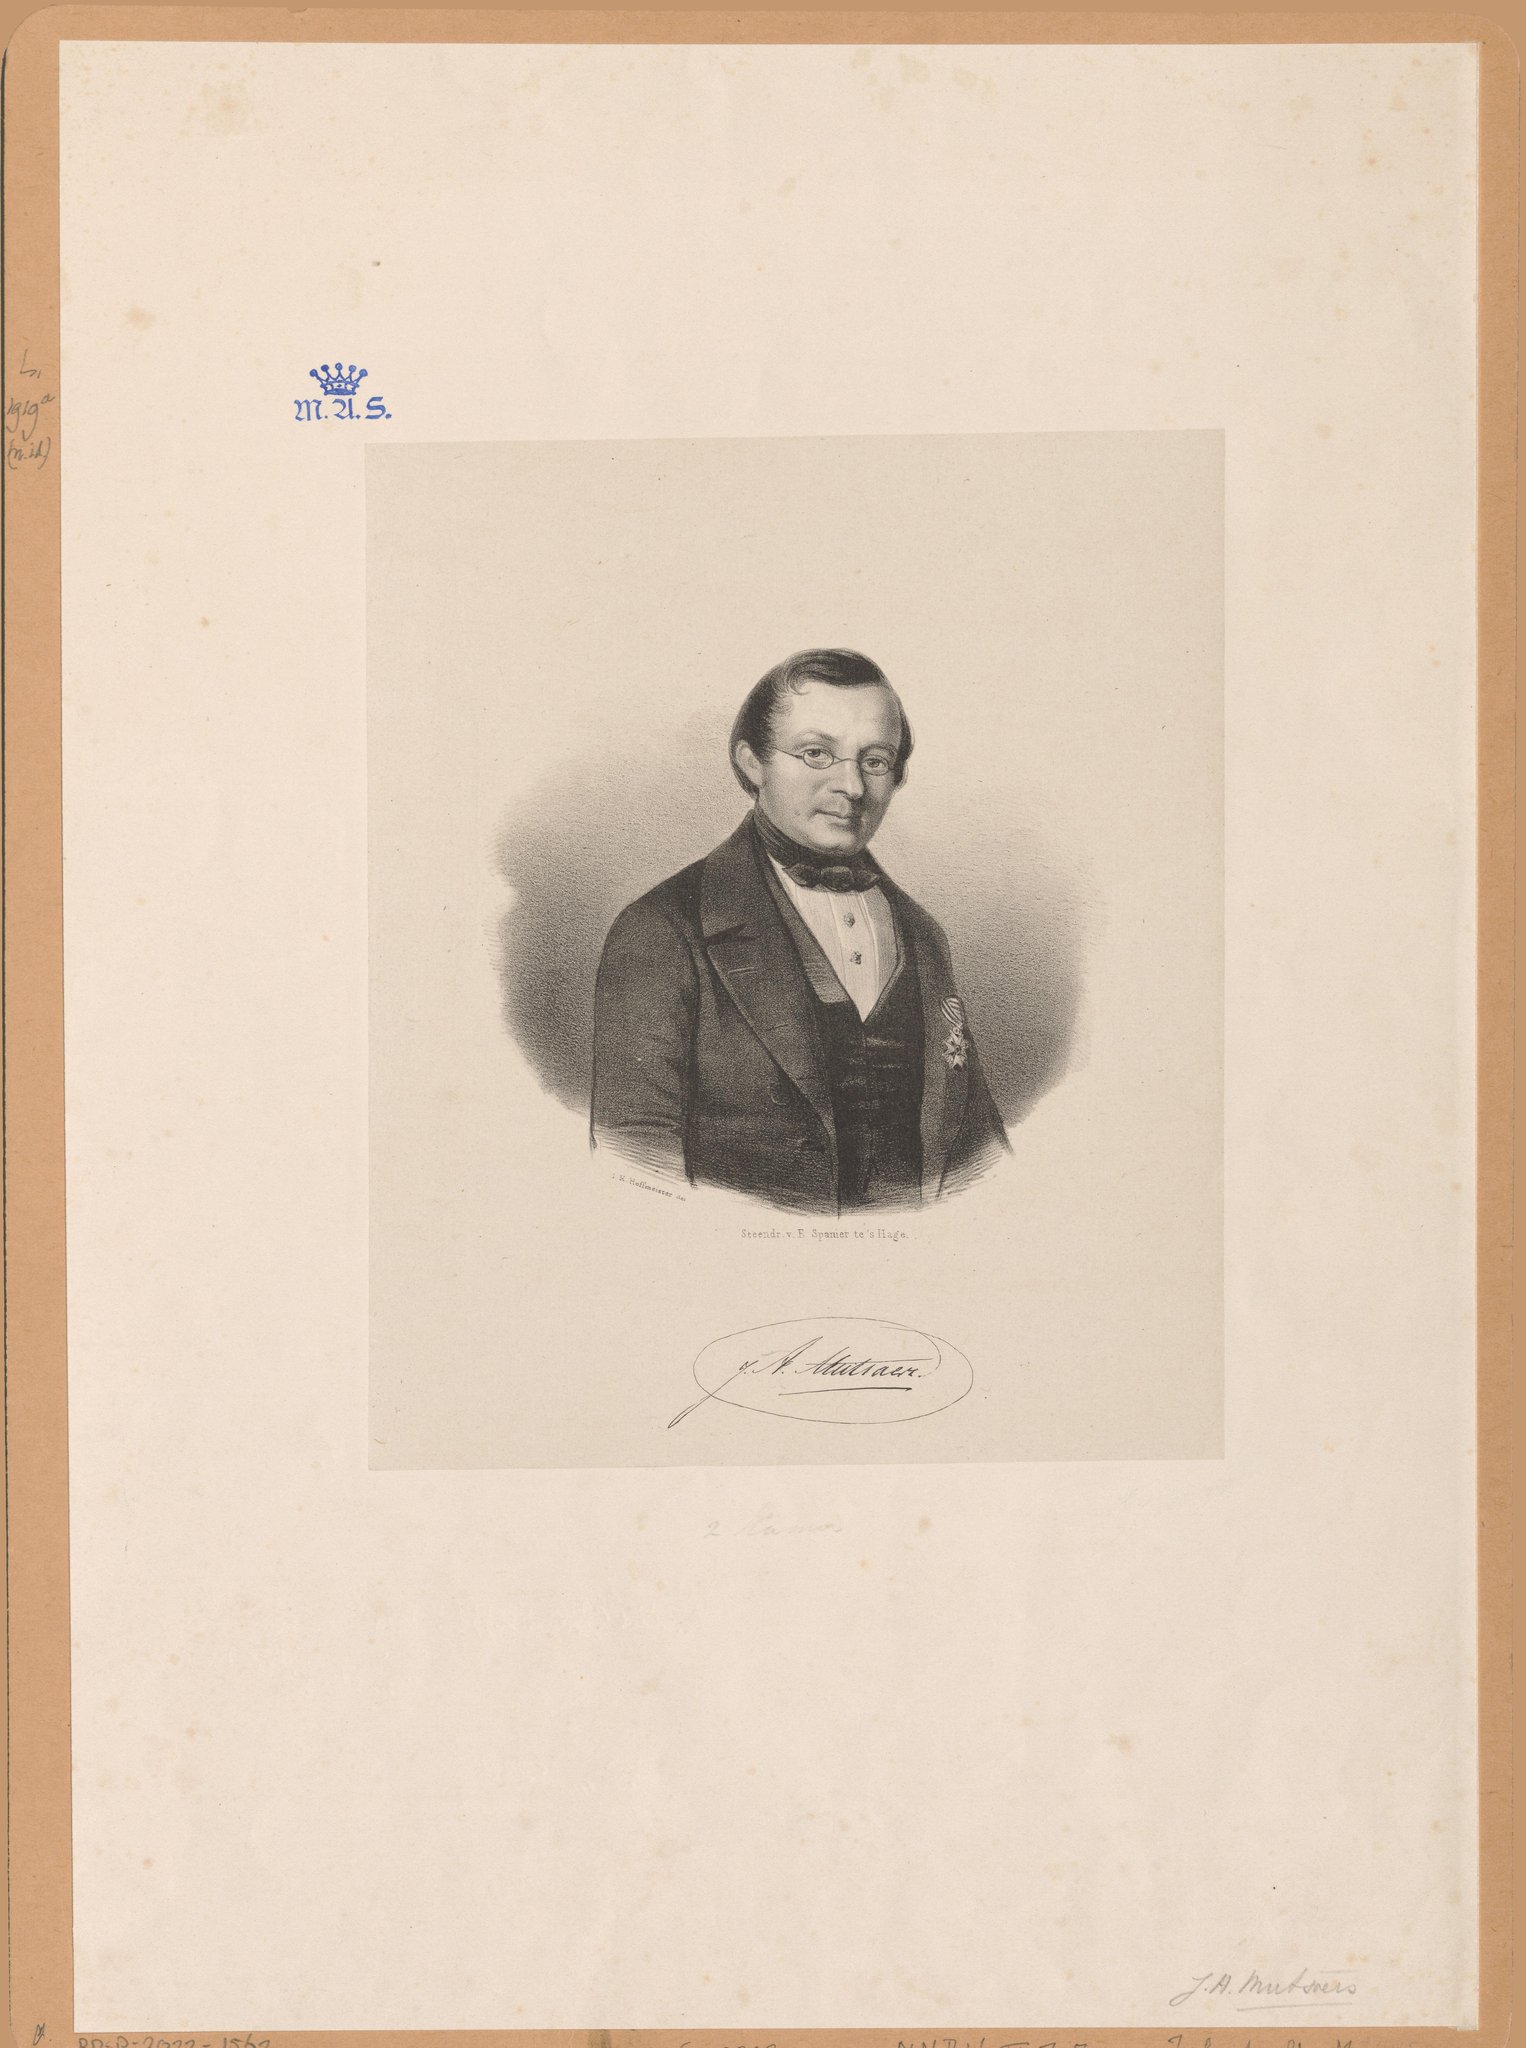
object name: print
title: Portret van Jacobus Arnoldus Mutsaers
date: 1843-1863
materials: paper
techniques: lithograph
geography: netherlands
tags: historical persons, politician, e.g. party leader, magistracy, judges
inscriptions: collector's mark: Lugt 1919a